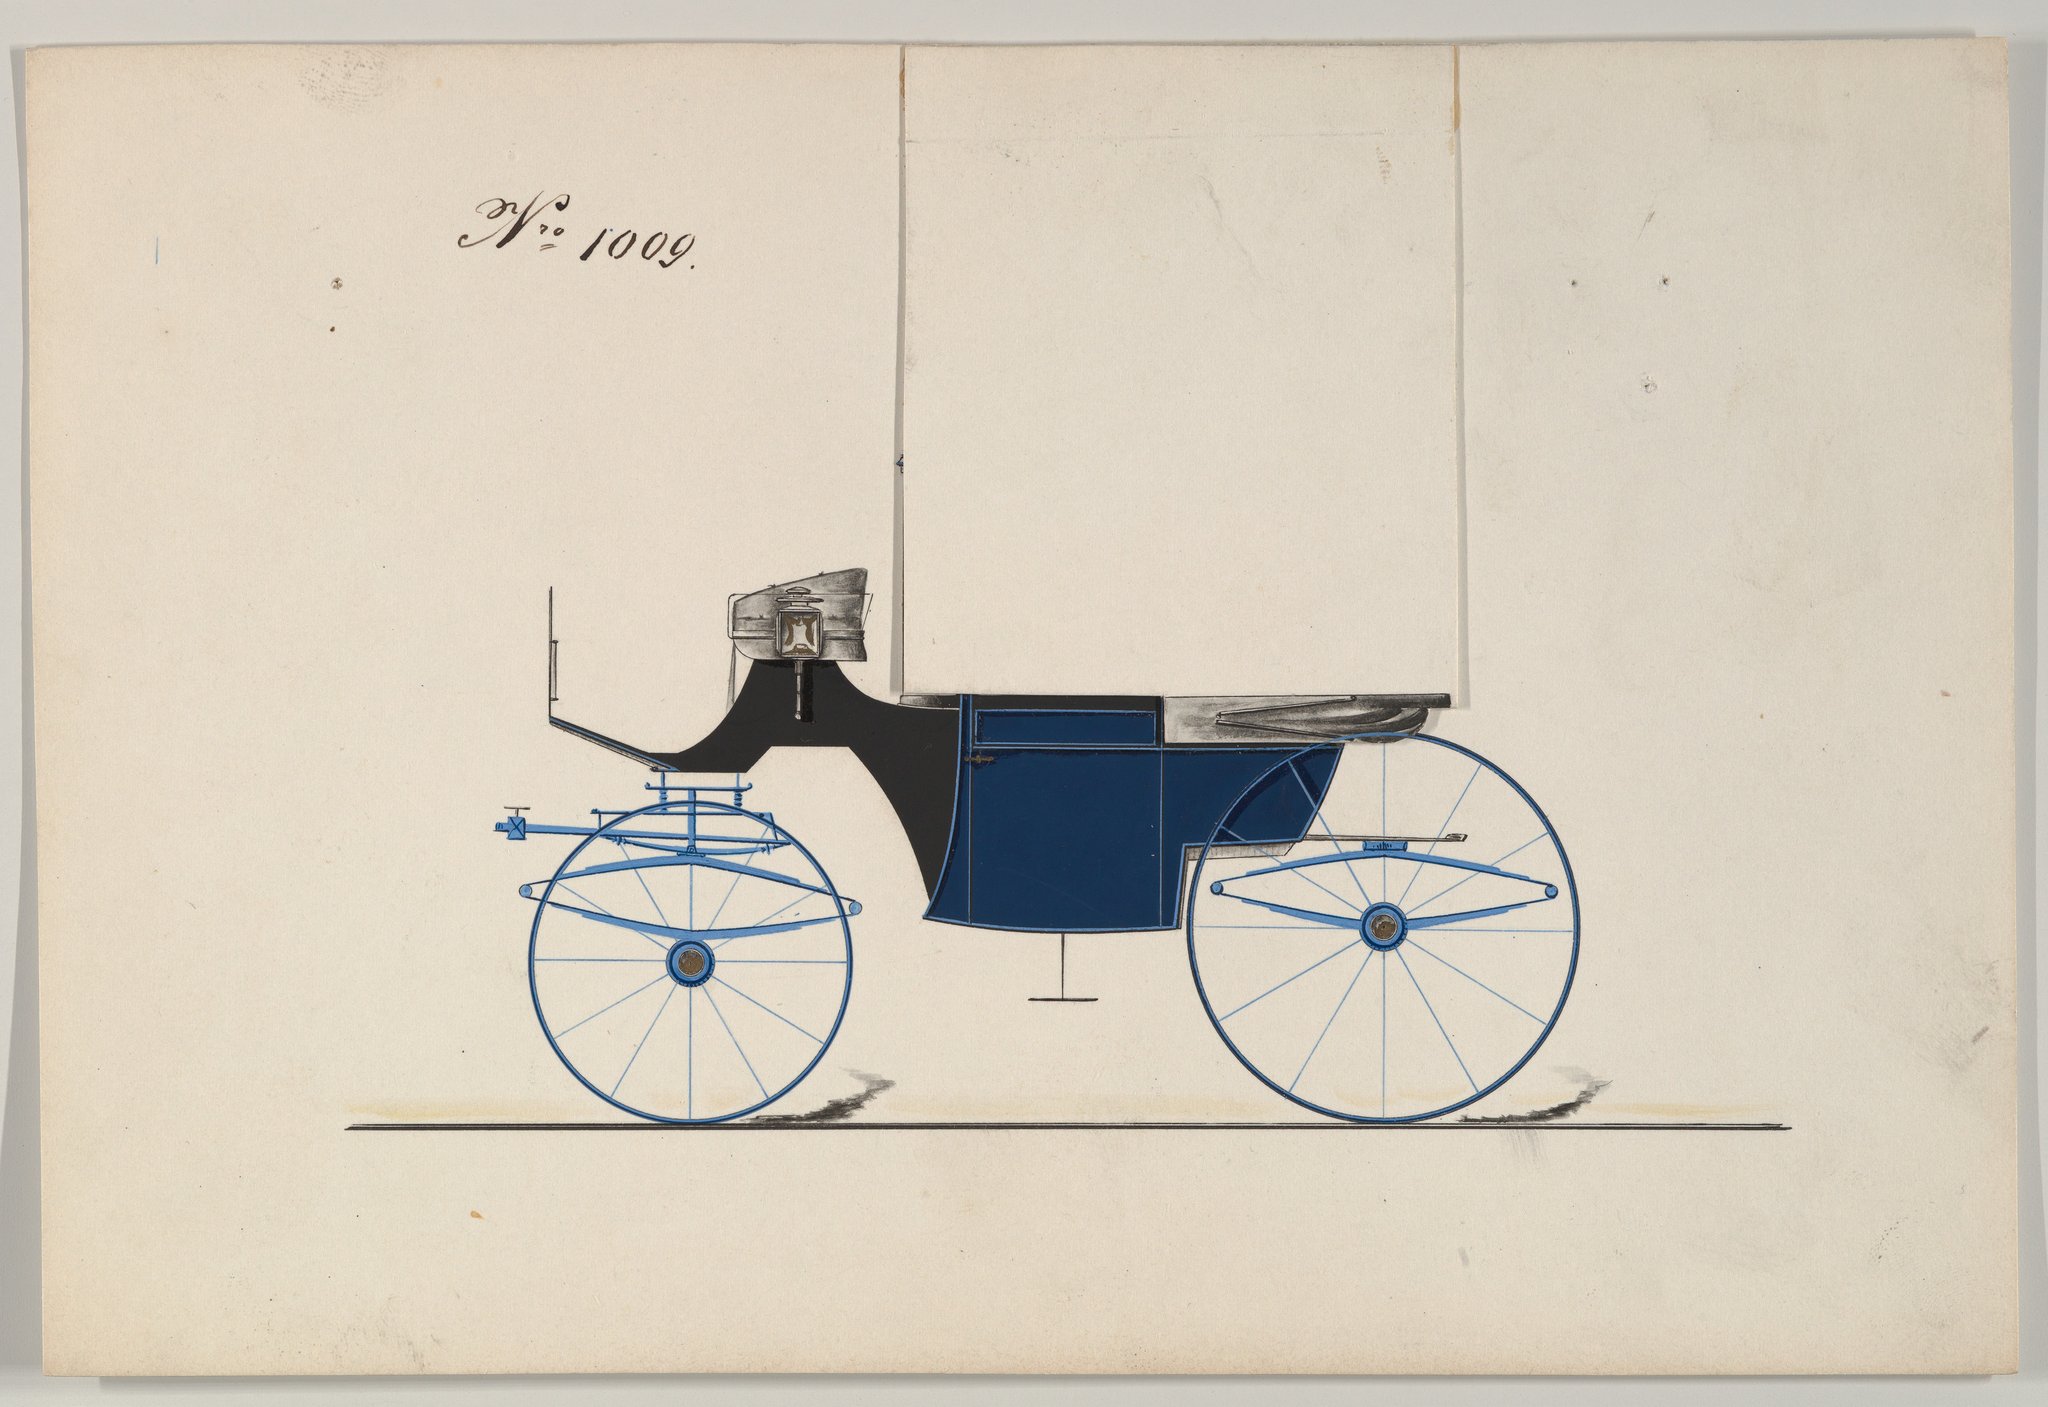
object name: drawing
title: Landaulet #1009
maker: brewster & co.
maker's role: manufacturer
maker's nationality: american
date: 1850-1870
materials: gouache, gum arabic, ink, watercolor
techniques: pen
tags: carriages